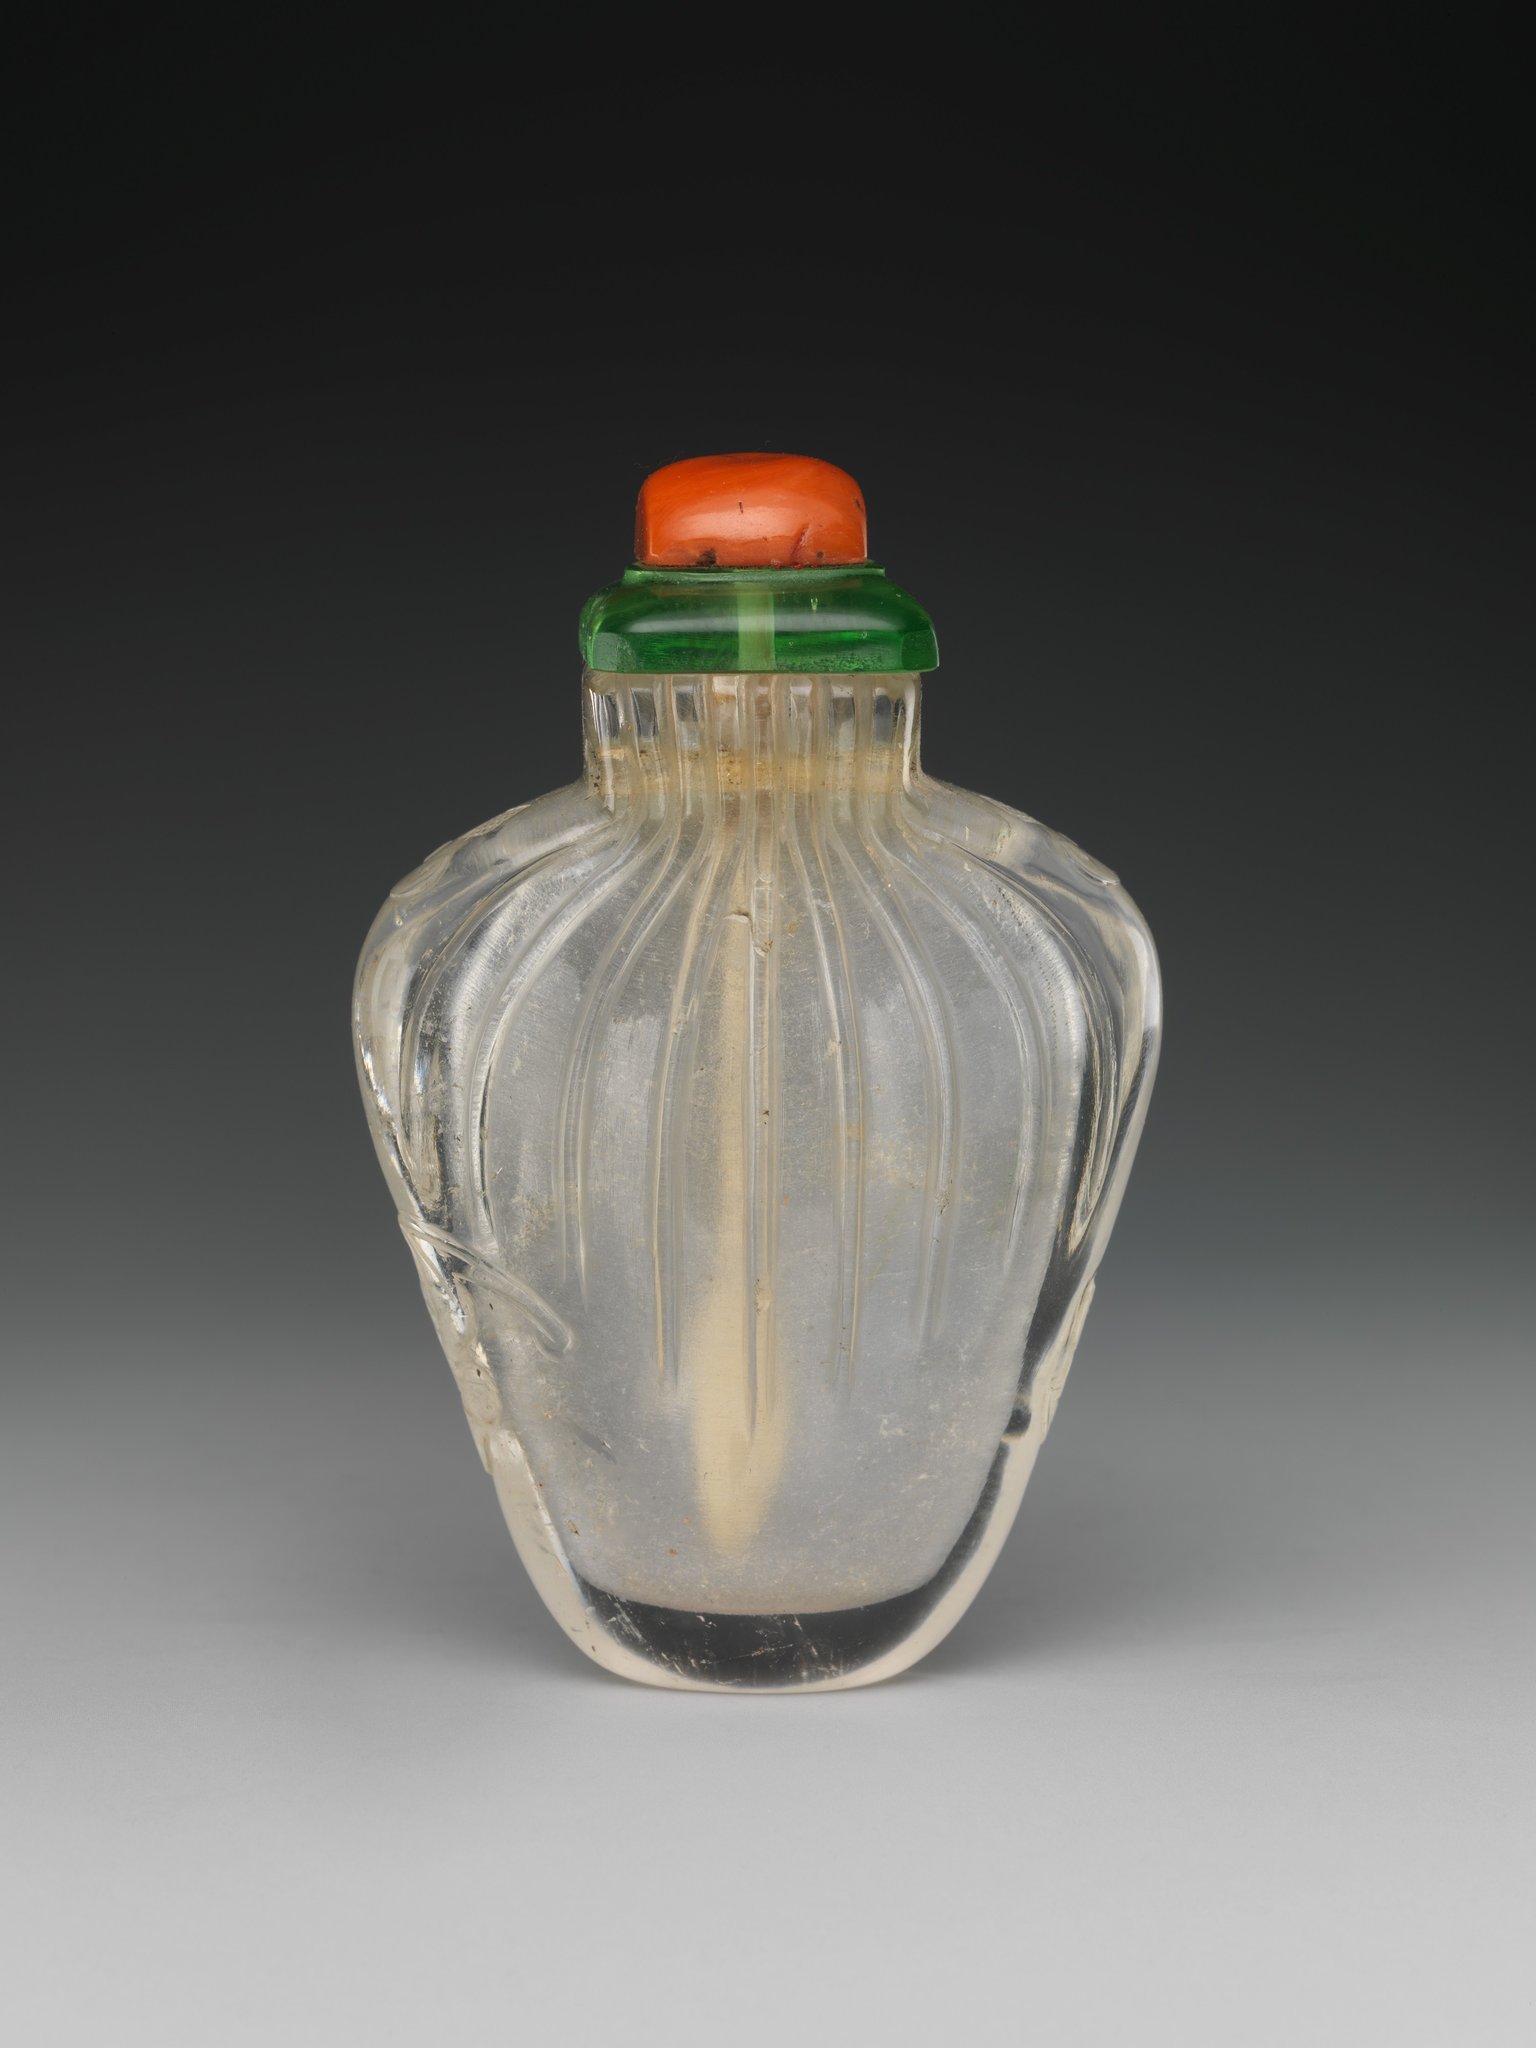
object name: snuff bottle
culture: chinese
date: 1767-1833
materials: coral, glass, quartz